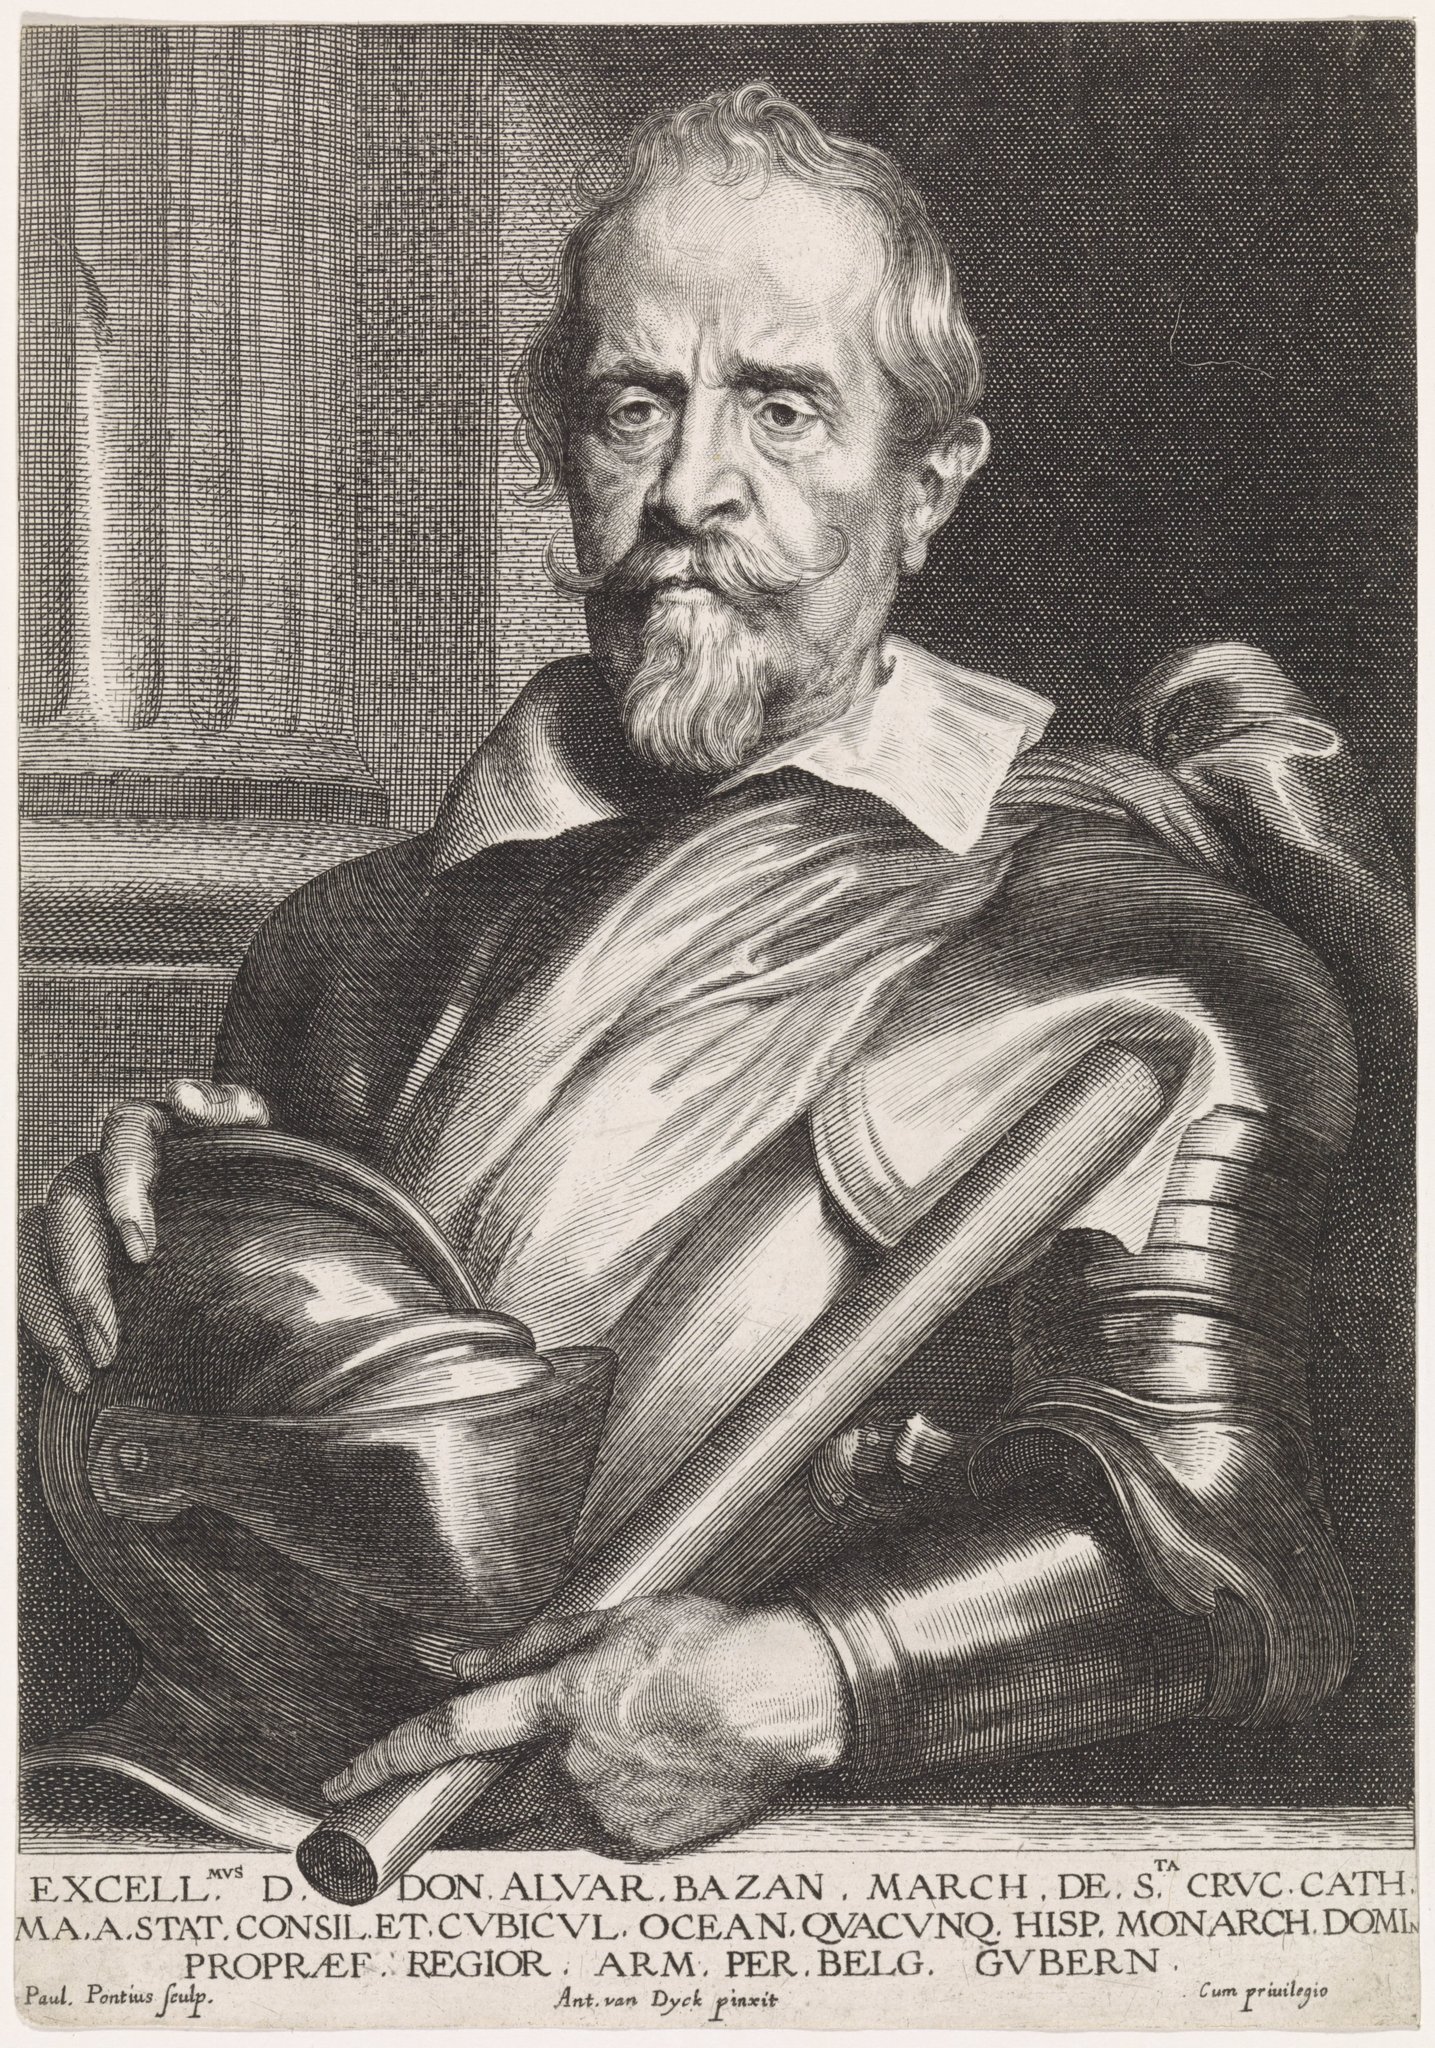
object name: print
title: Portret van de commandant Don Álvaro de Bazán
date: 1616-1657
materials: paper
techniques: engraving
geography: antwerp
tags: álvaro de bazán, armour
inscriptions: collector's mark: Lugt 2228